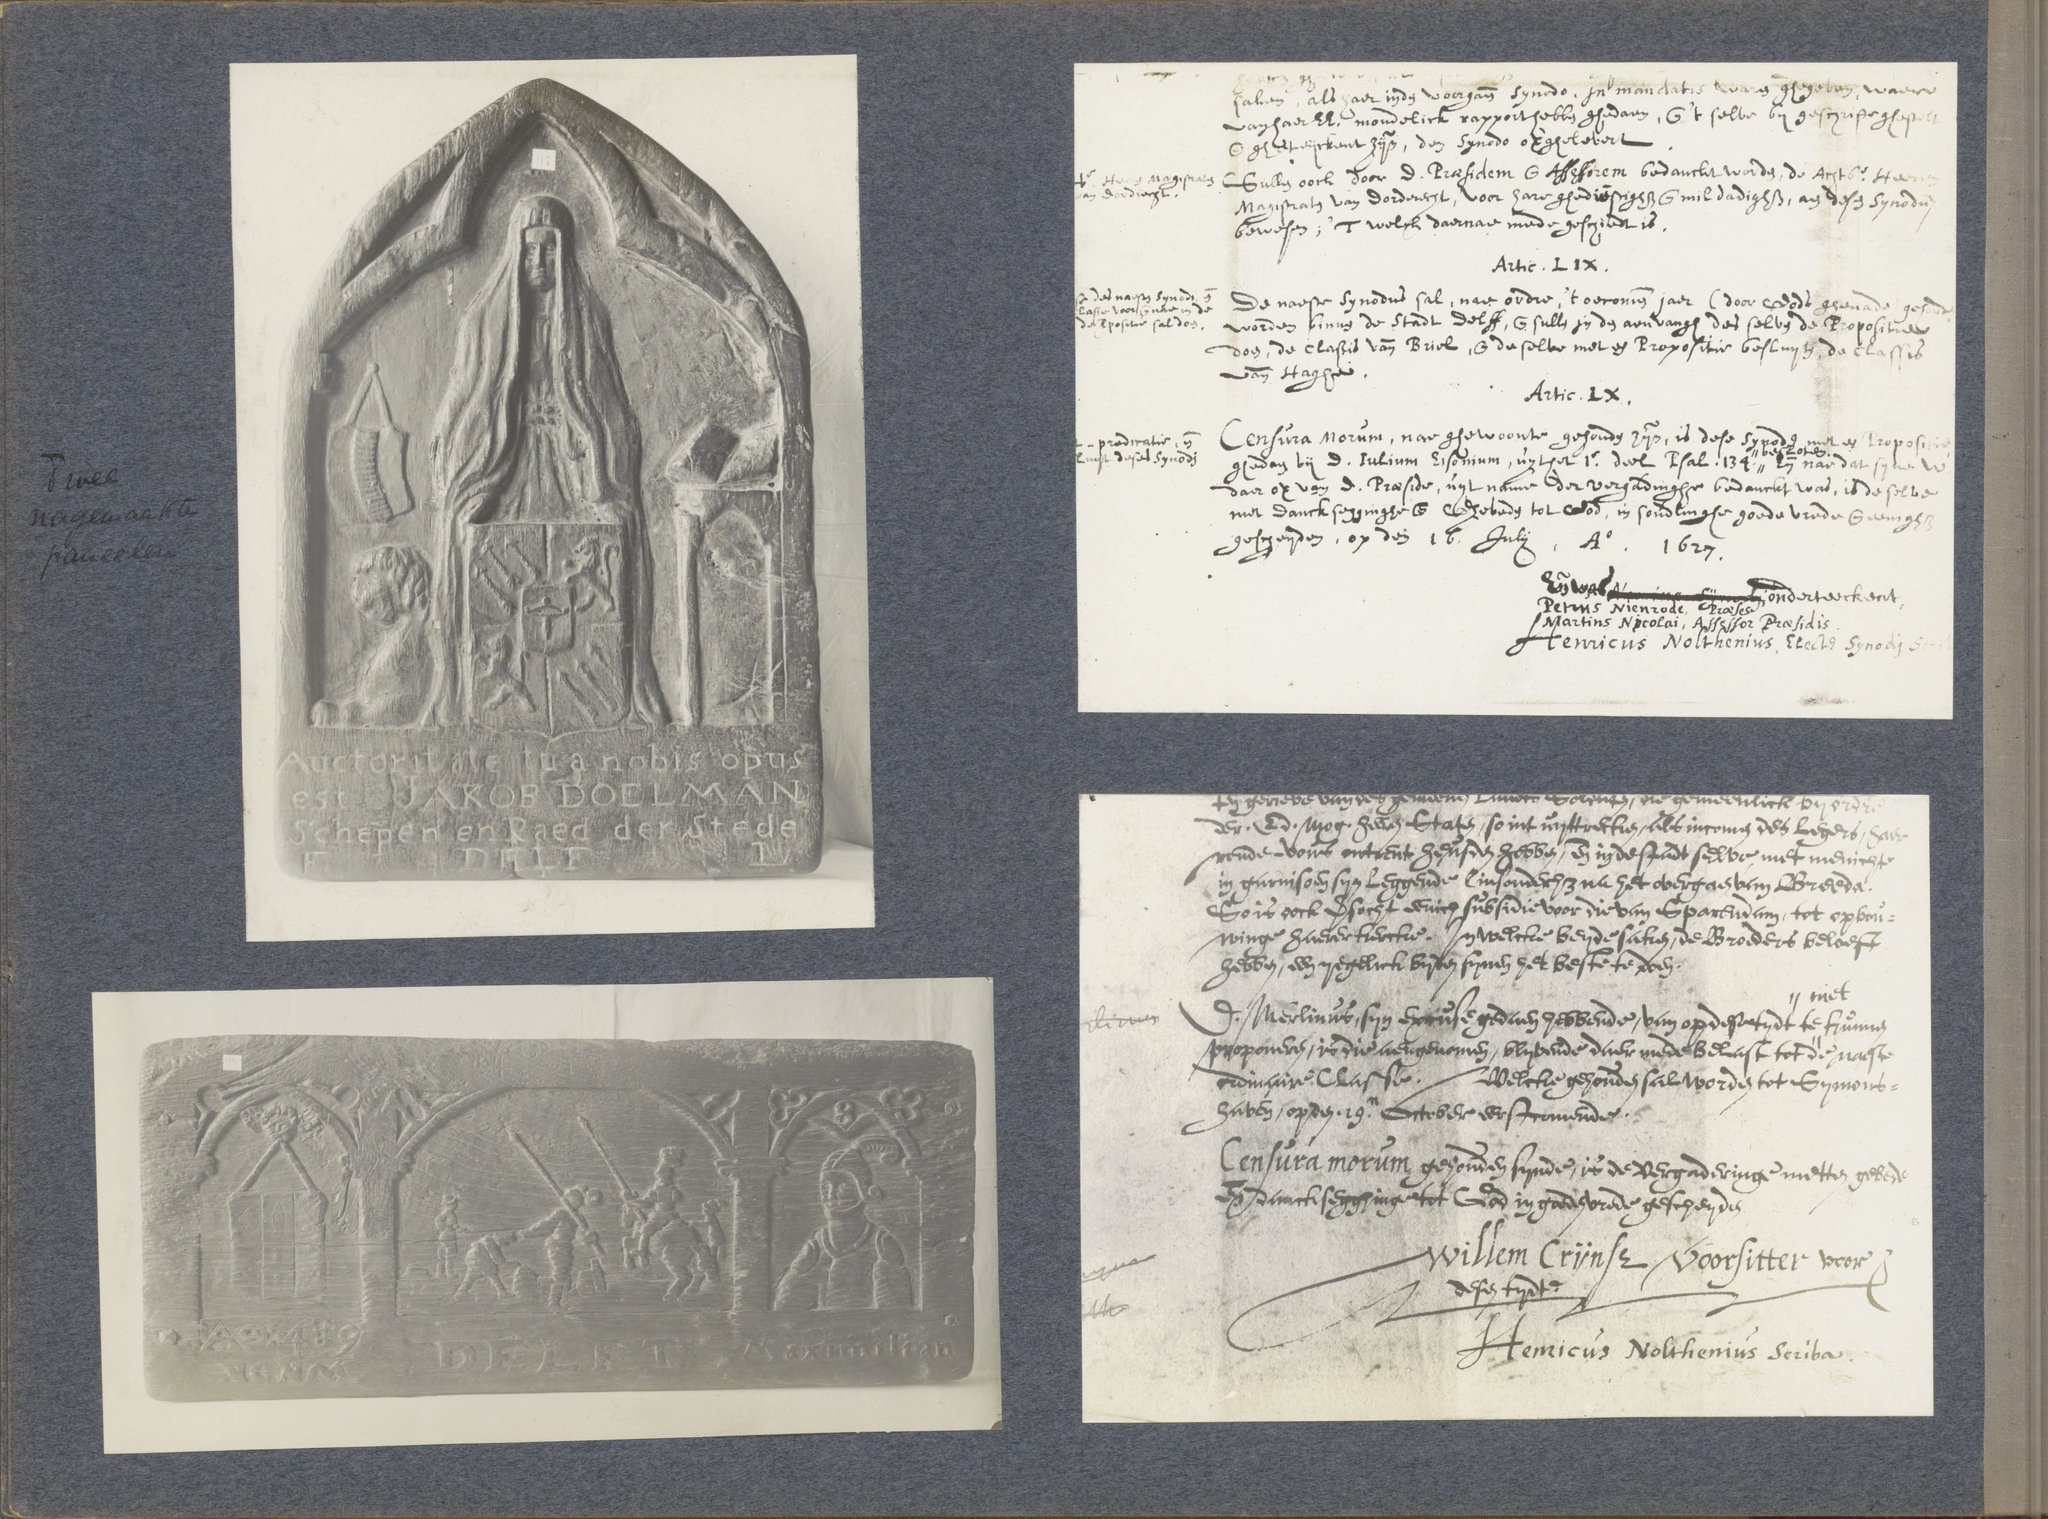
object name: photograph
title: Panelen en oude handschriften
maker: Anonymous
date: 1910-1911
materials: cardboard, paper, photographic support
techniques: gelatin silver print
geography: netherlands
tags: handwriting, written text, wall-covering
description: Albumblad met vier foto's van twee (blijkens het bijschrift) nagemaakte houten panelen betrekking hebbend op de stad Delft en van twee zeventiende-eeuwse handschriften. Eén van de houten panelen draagt de naam Jakob Doelman. Onderdeel van Fotoalbum van de familie Palthe uit Almelo.